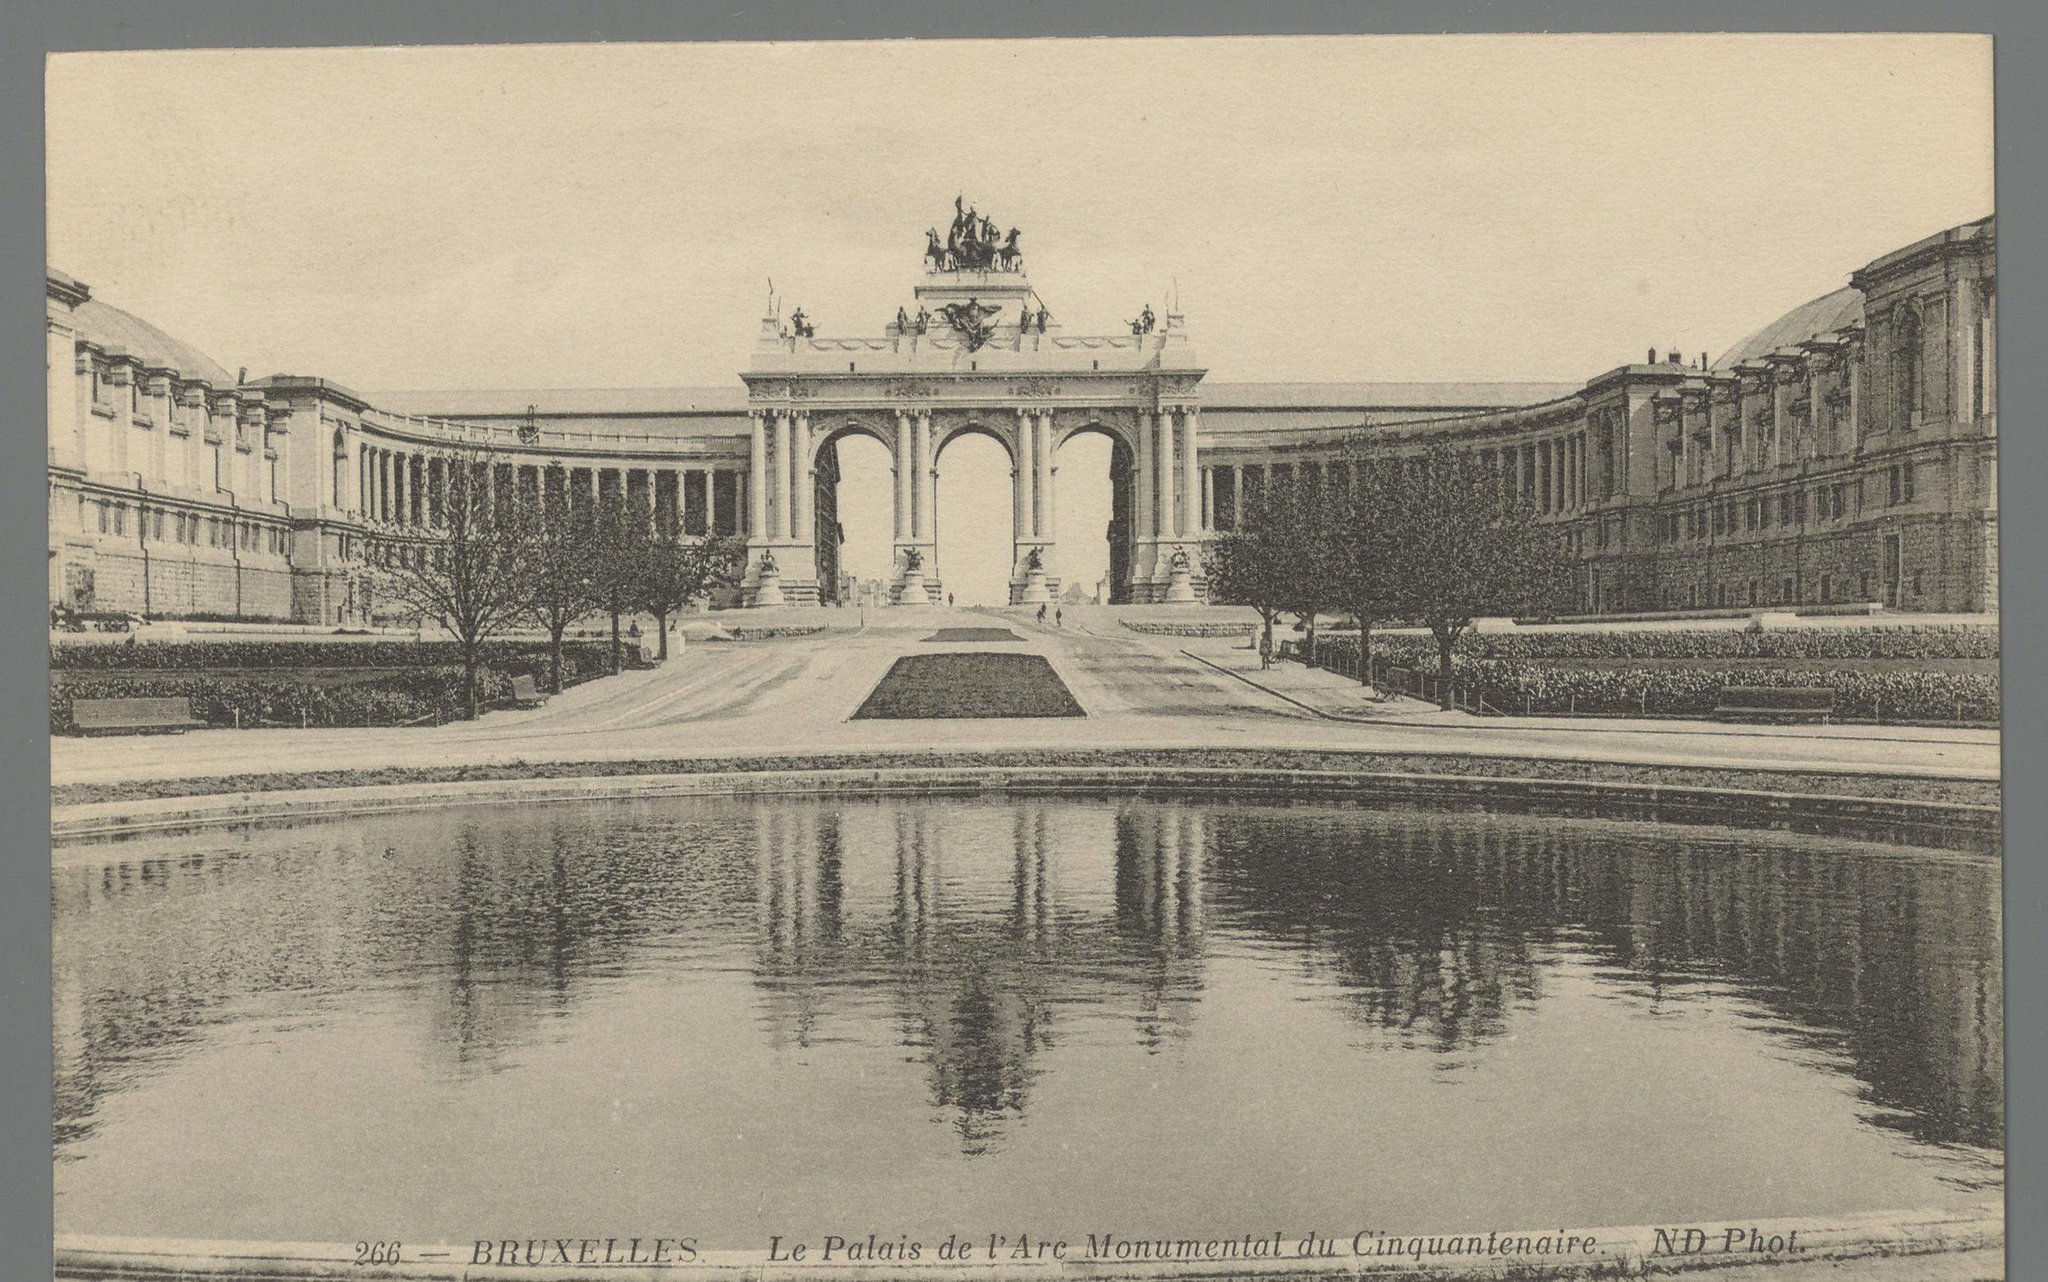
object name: photomechanical print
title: Bruxelles. Le Palais de l'Arc Monumental du Cinquantenaire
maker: Anonymous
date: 1906-1918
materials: cardboard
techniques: photograph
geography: brussels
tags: gate, entrance, monument, statue, public gardens, park